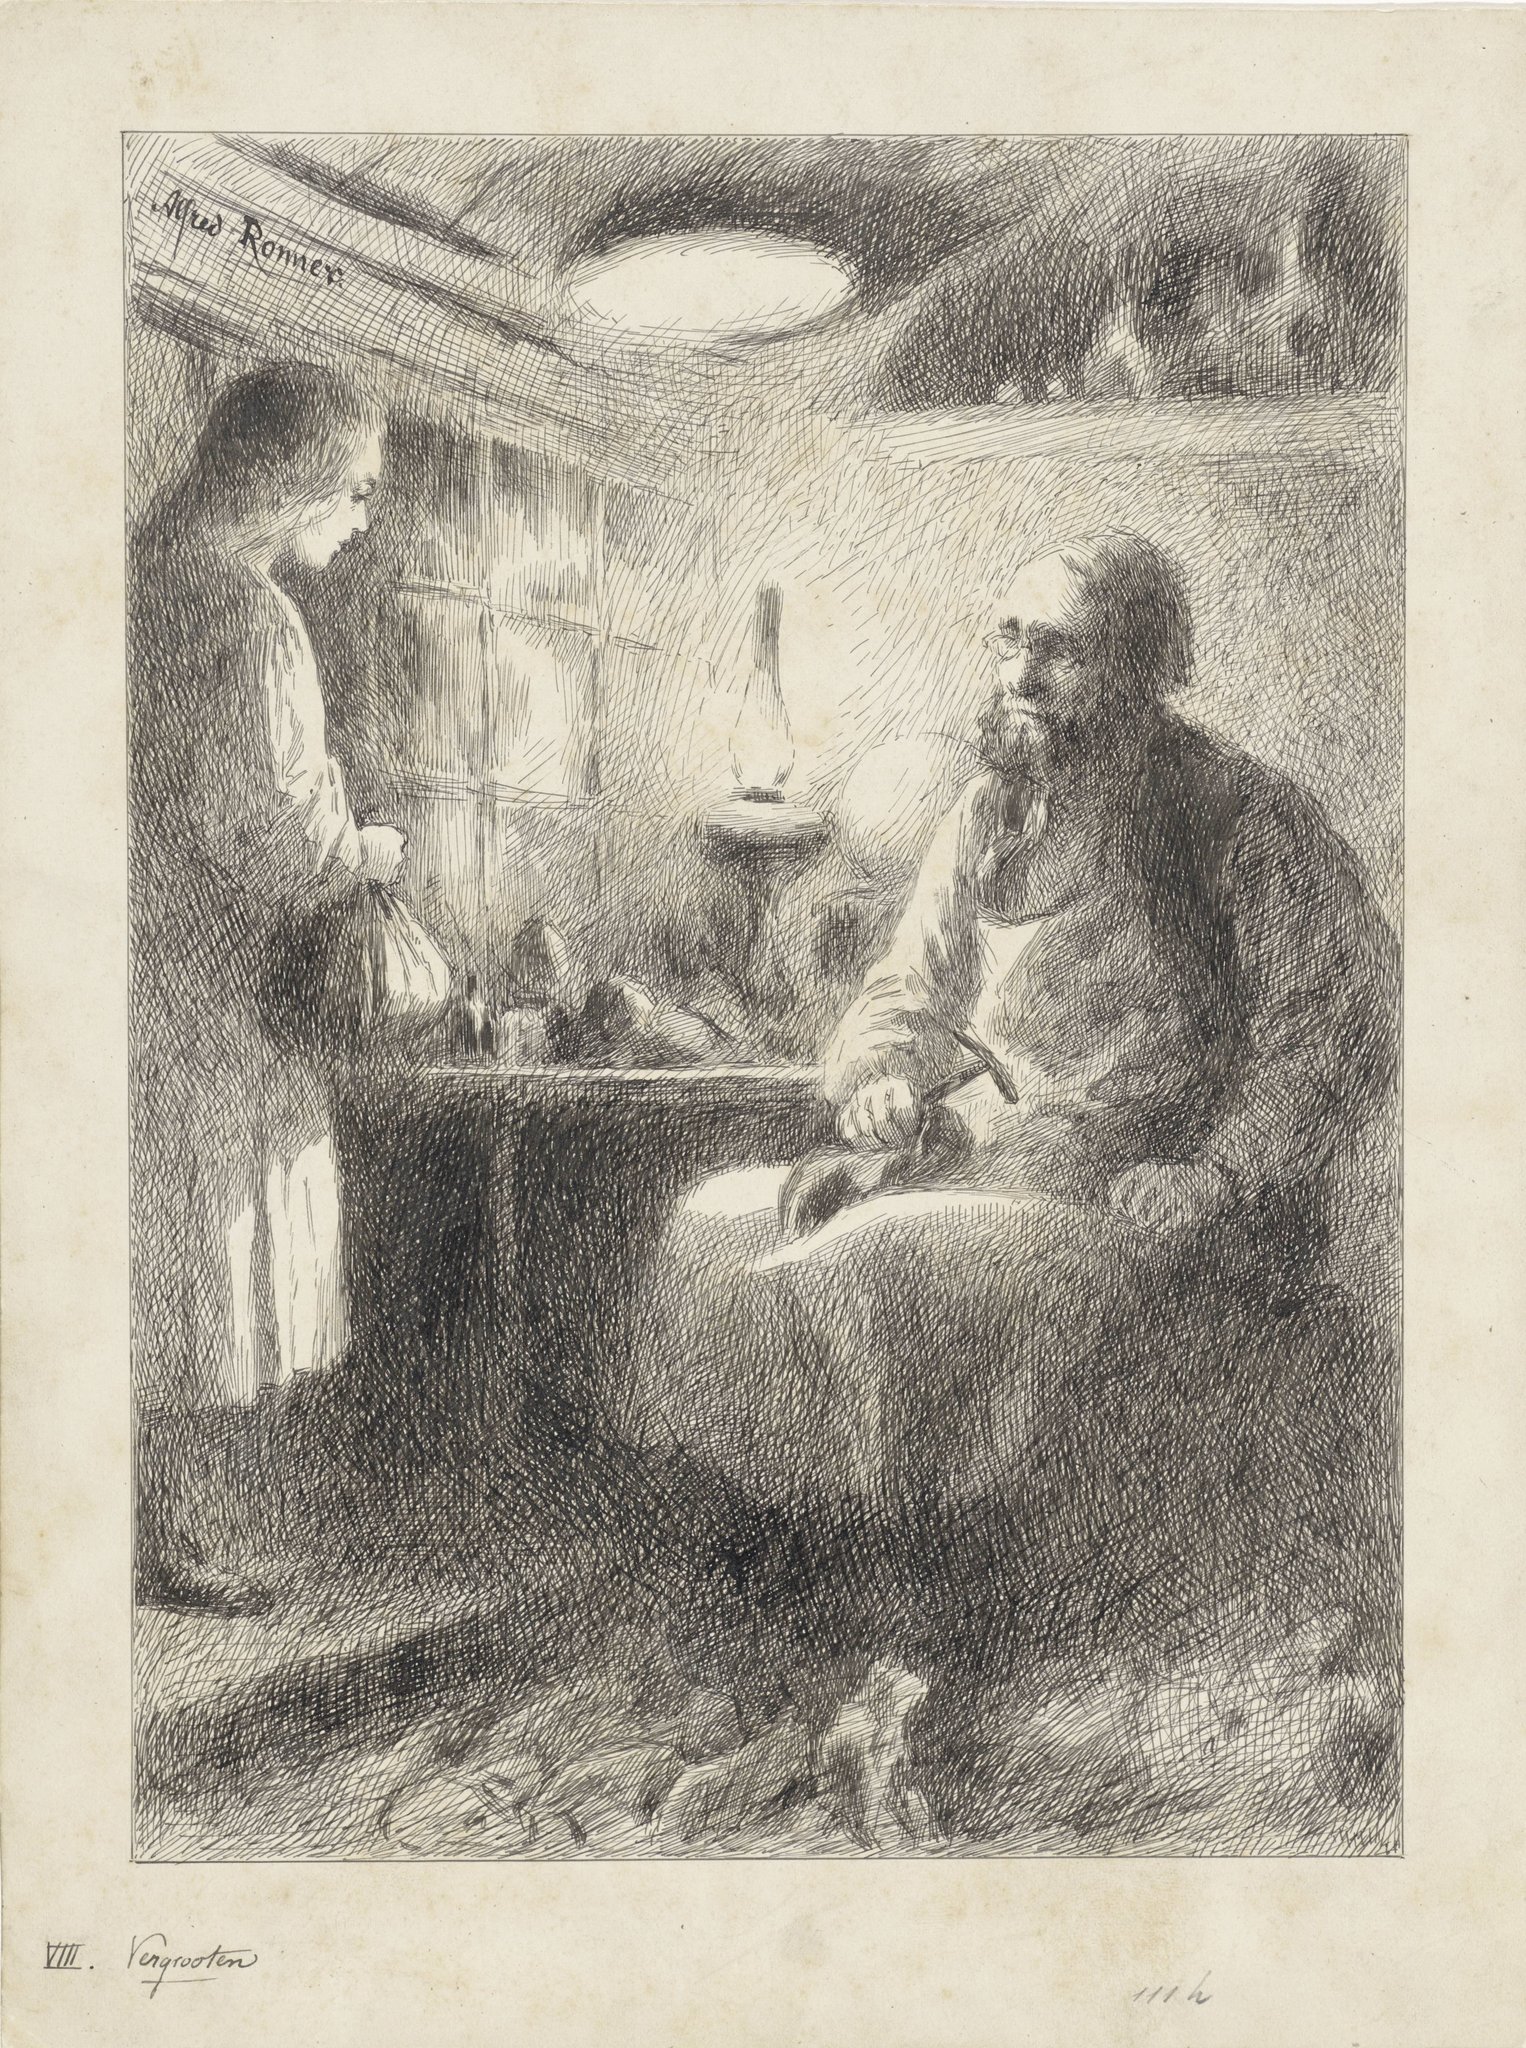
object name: design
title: Vergrooten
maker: alfred ronner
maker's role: draughtsman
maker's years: 1852-1901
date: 1893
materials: ink, paper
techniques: pen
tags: (reiger, a.f.j., vluchtige schetsen uit het volksleven) specific works of literature (with author, title), shoe-maker, cobbler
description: Illustratie voor 'Vluchtige Schetsen uit het Volksleven' door A.F.J. Reiger. Ontwerp voor een prent.